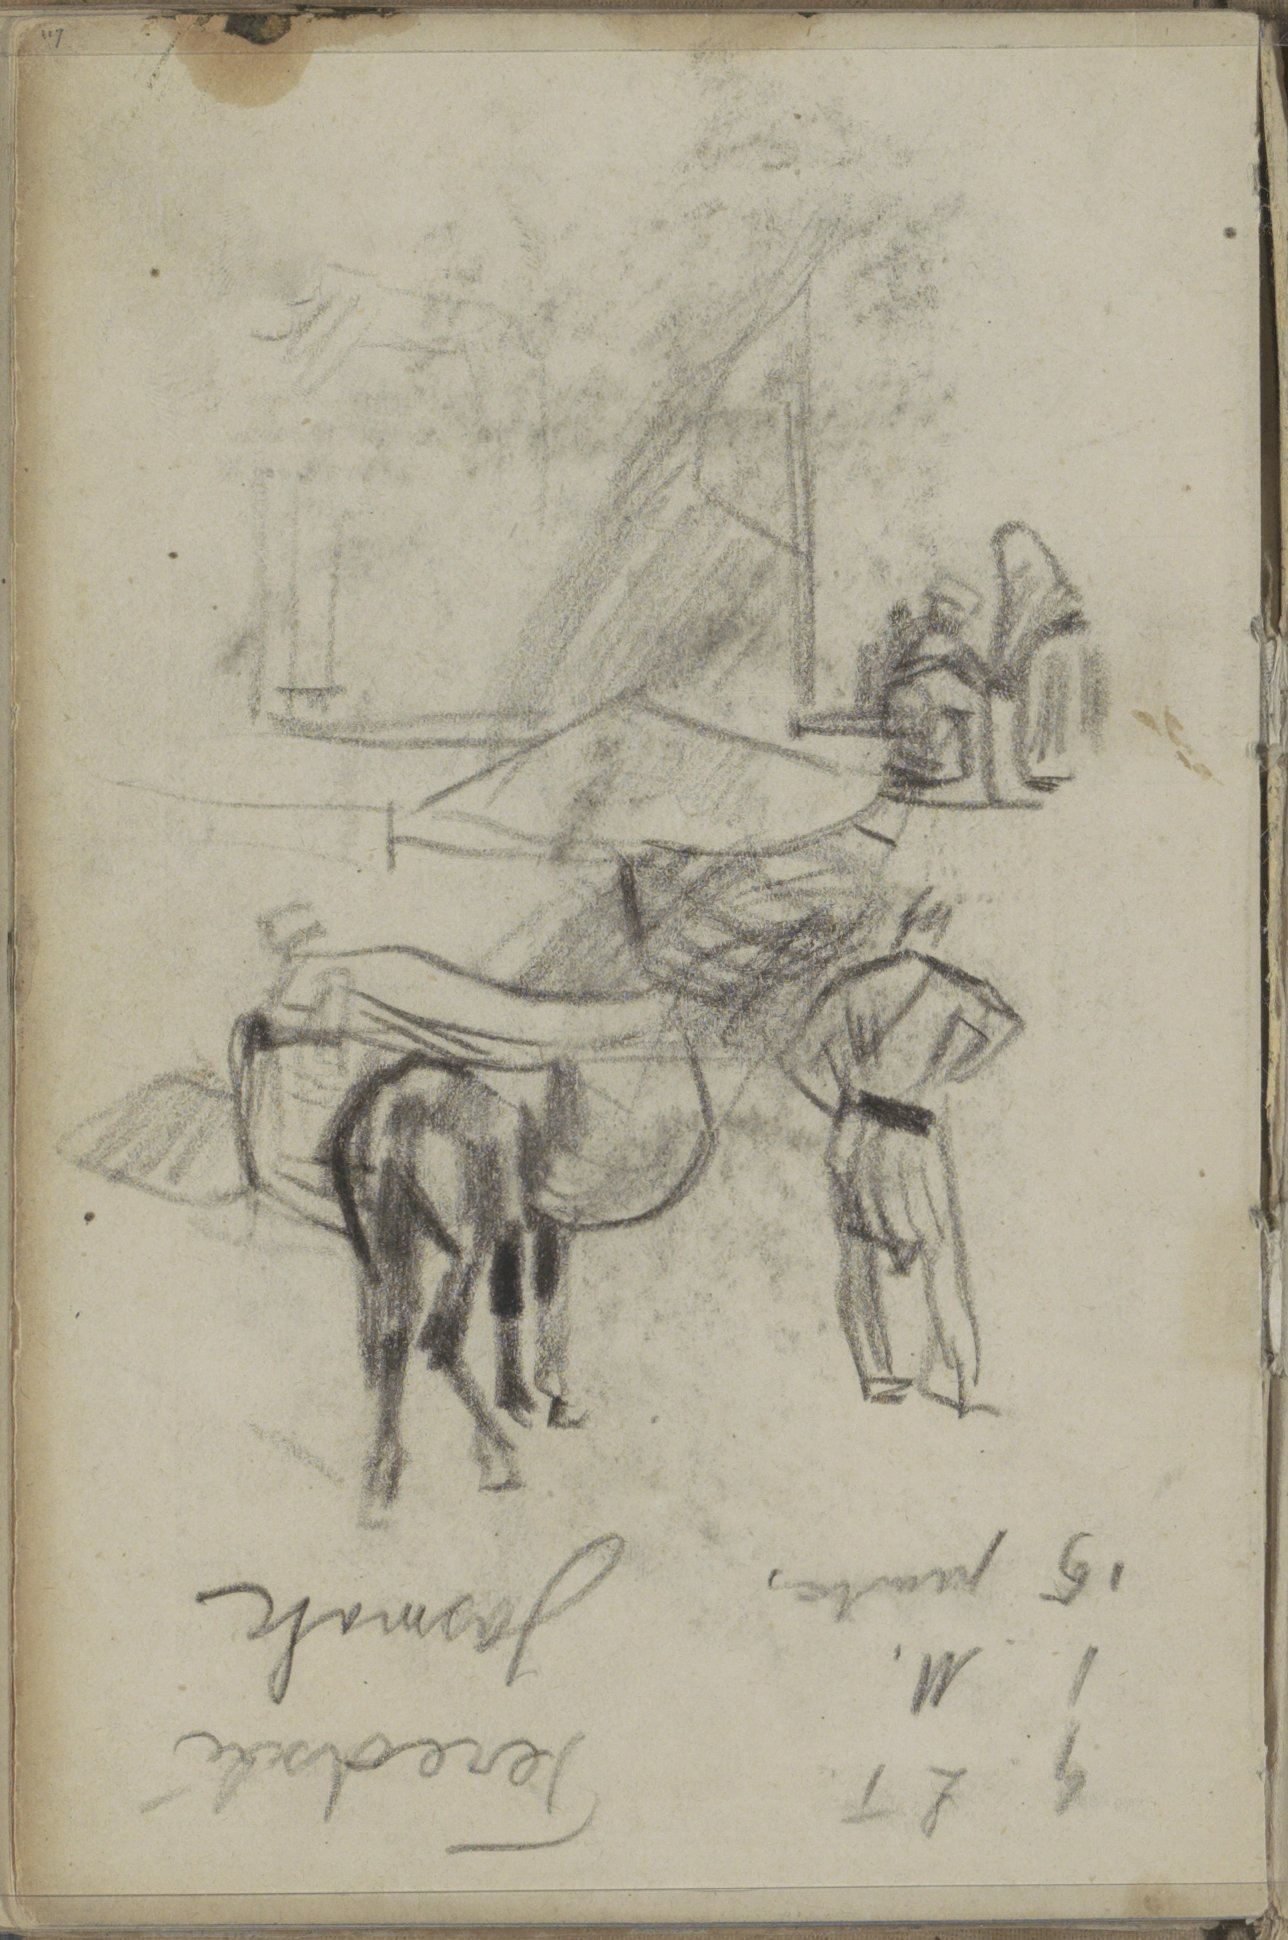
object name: sketchbook leaf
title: Paard en figuurstudies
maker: marius bauer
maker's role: draughtsman, print maker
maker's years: 1867-1932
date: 1888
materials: chalk, paper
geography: istanbul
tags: standing figure, horse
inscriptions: annotation: ‘4 LT Teredsché/ 1 M/ 15 pr[..] Jasmak’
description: Pagina 117 uit een schetsboek met 58 bladen.